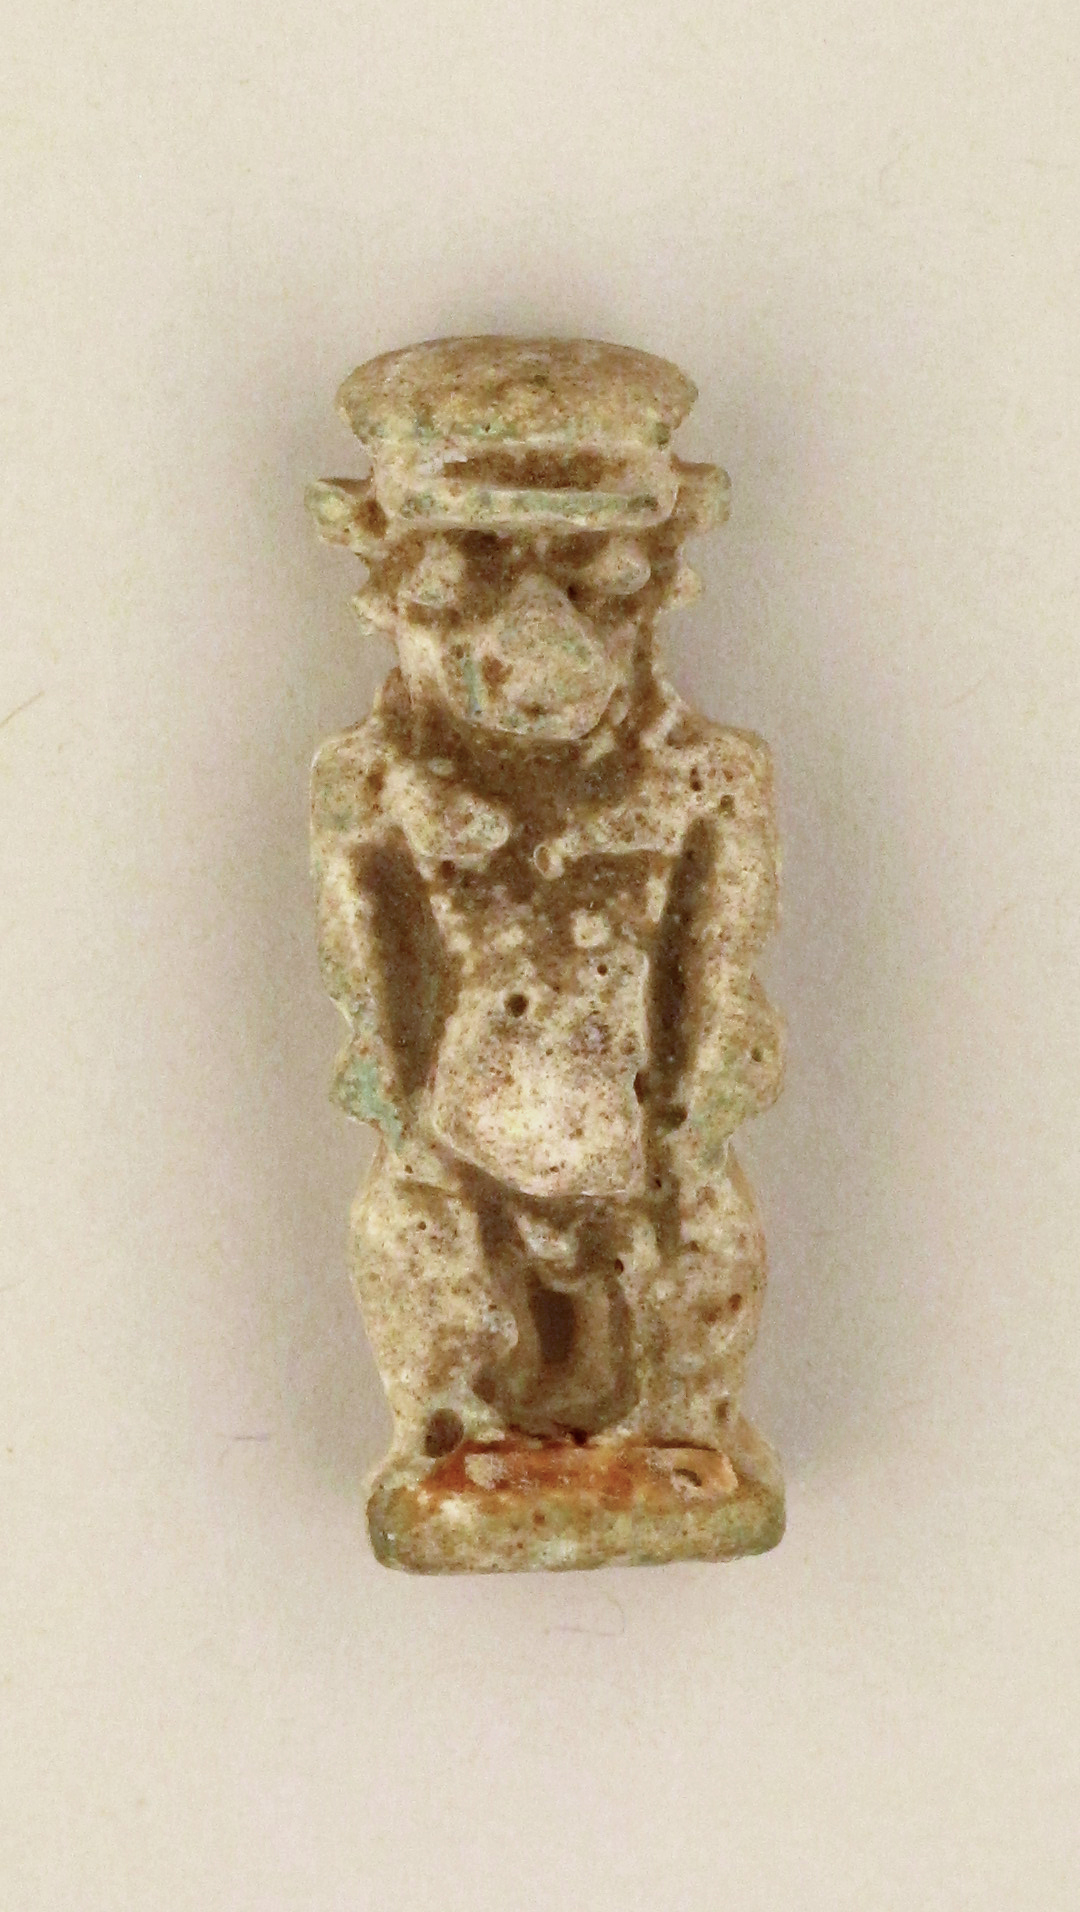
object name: amulet, ptah seker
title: Faience amulet in the form of the dwarf god Pataikos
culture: egyptian, ptolemaic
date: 664-630 BCE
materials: faience